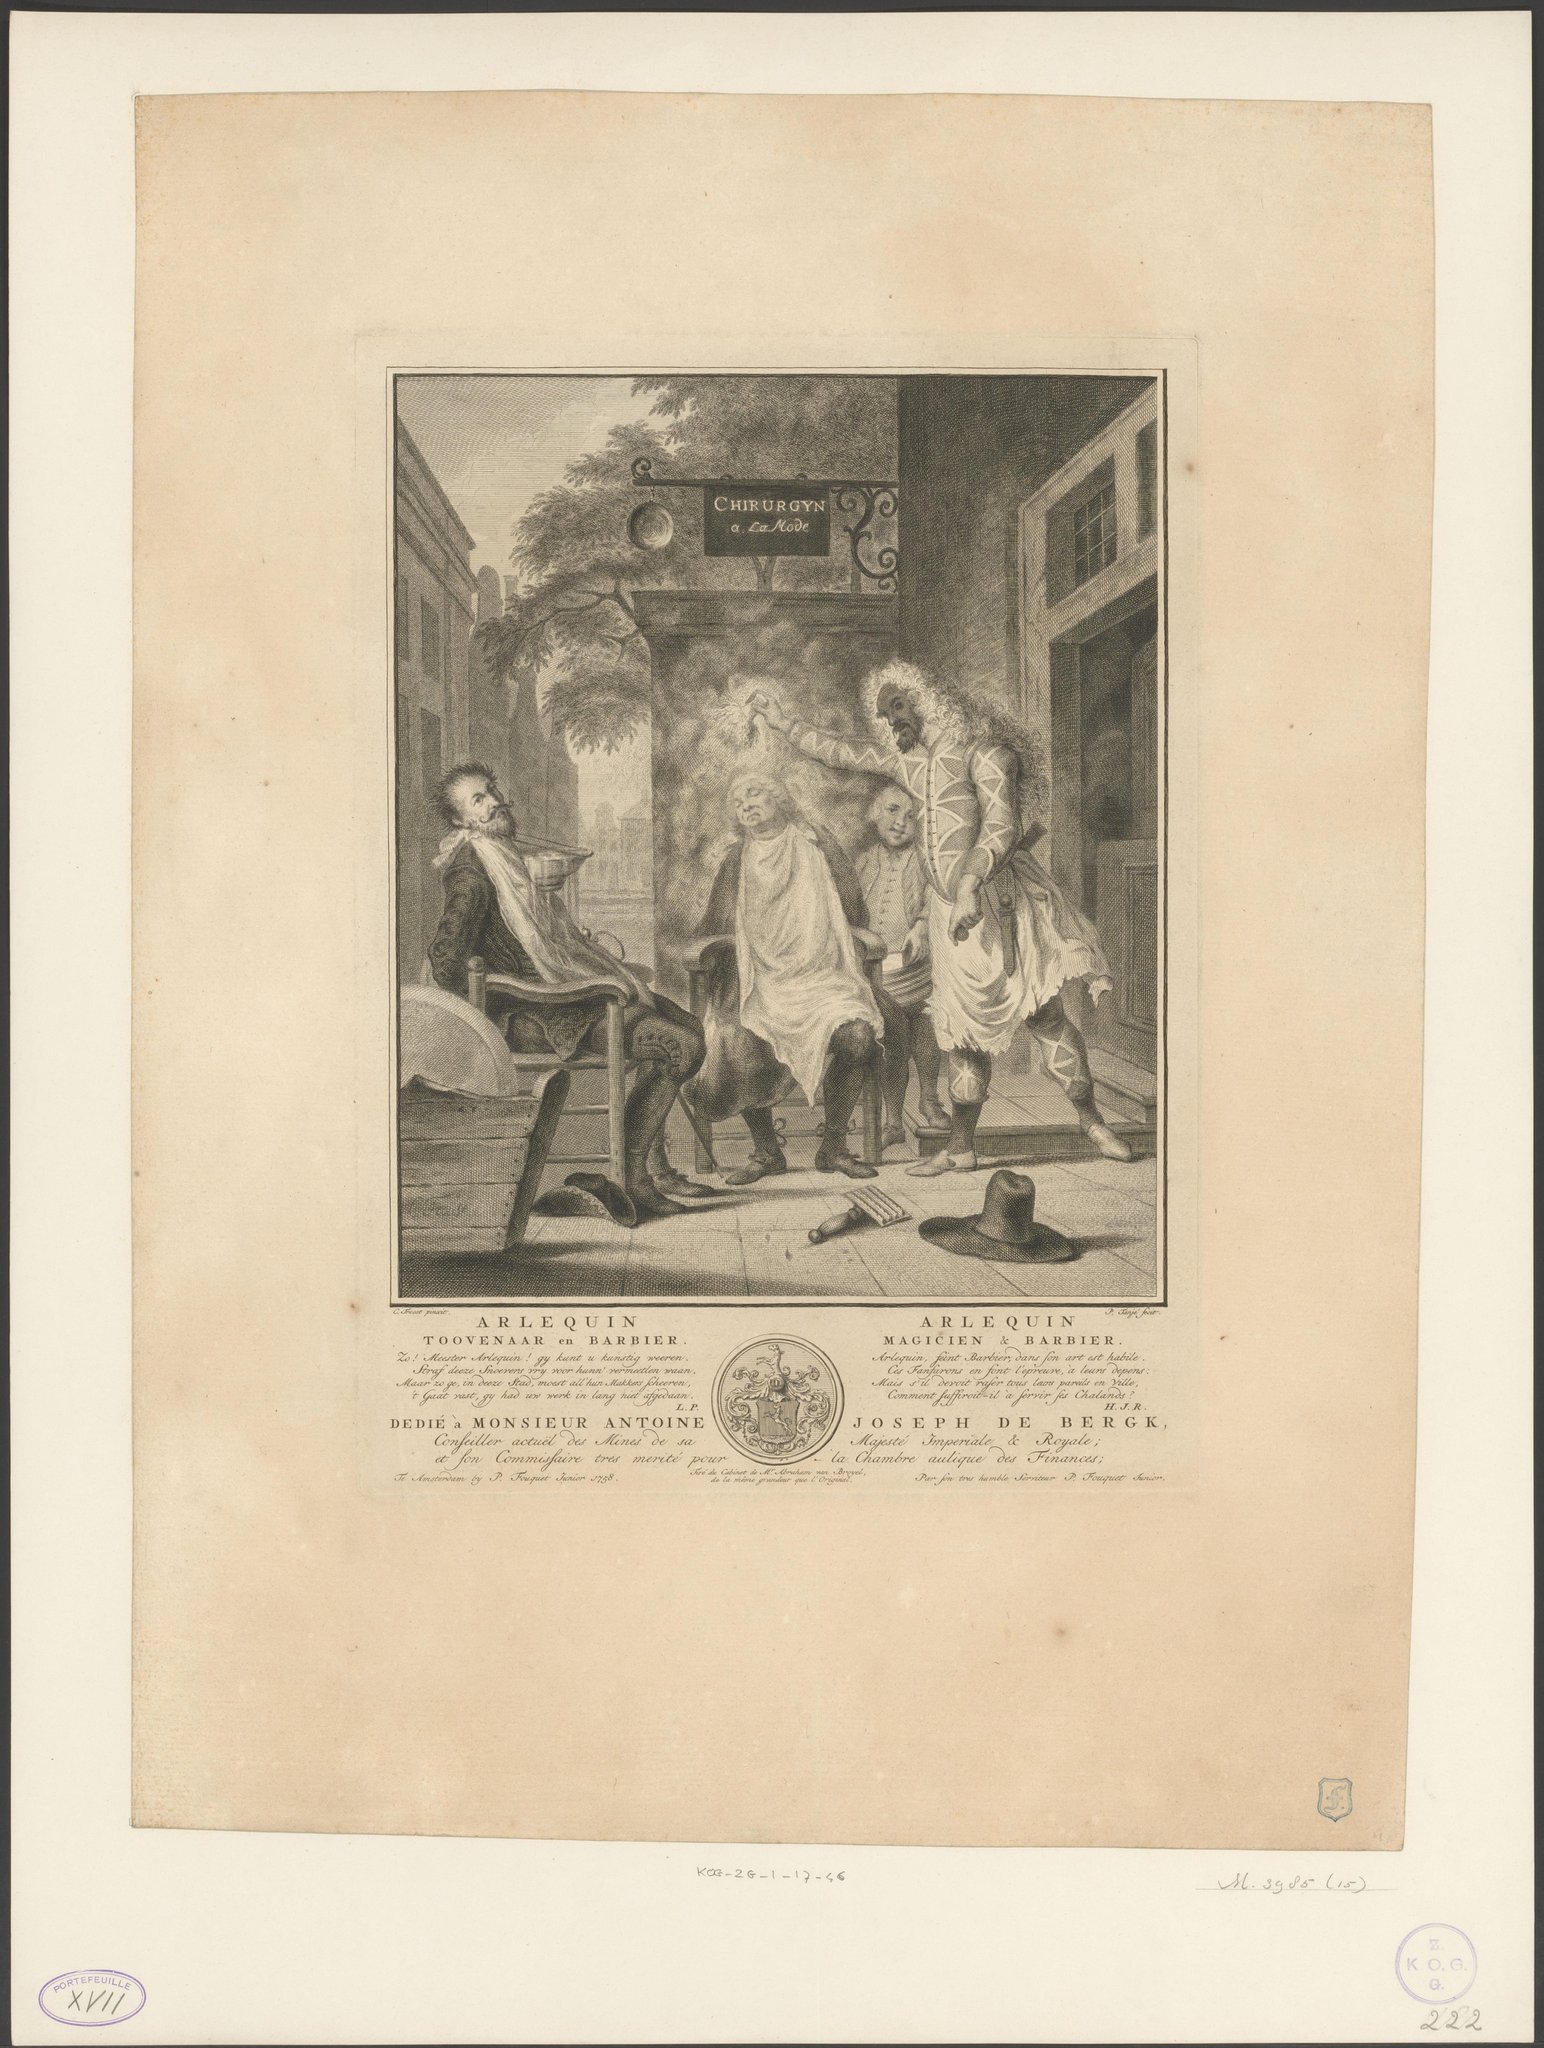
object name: print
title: Arlequin toovenaar en barbier / Arlequin magicien & barbier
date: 1758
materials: paper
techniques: engraving, etching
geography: amsterdam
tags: types in 'commedia dell'arte': harlequin, 'commedia dell'arte', barber, barbershop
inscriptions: stamp, collector's mark: Lugt 963, collector's mark: Lugt 1641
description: Belloardo en Capitano worden door de als barbier verklede Arlequin hardhandig geschoren en bepoedert met natgemaakt meel. Zijn knechtje Pierot houdt de bak met meel op. Arlequin heeft onder zijn linkerarm een knuppel verborgen waarmee hij zijn rivalen Belloardo en Capitano tot slot zal bewerken. Scène uit de klucht Arlequin, tovenaar, en barbier, van Willem van der Hoeven. Onderwerpsrubrieken binnen de Atlas Zeden en Gewoonten: Tooneel, Prenten van Cornelis Troost.